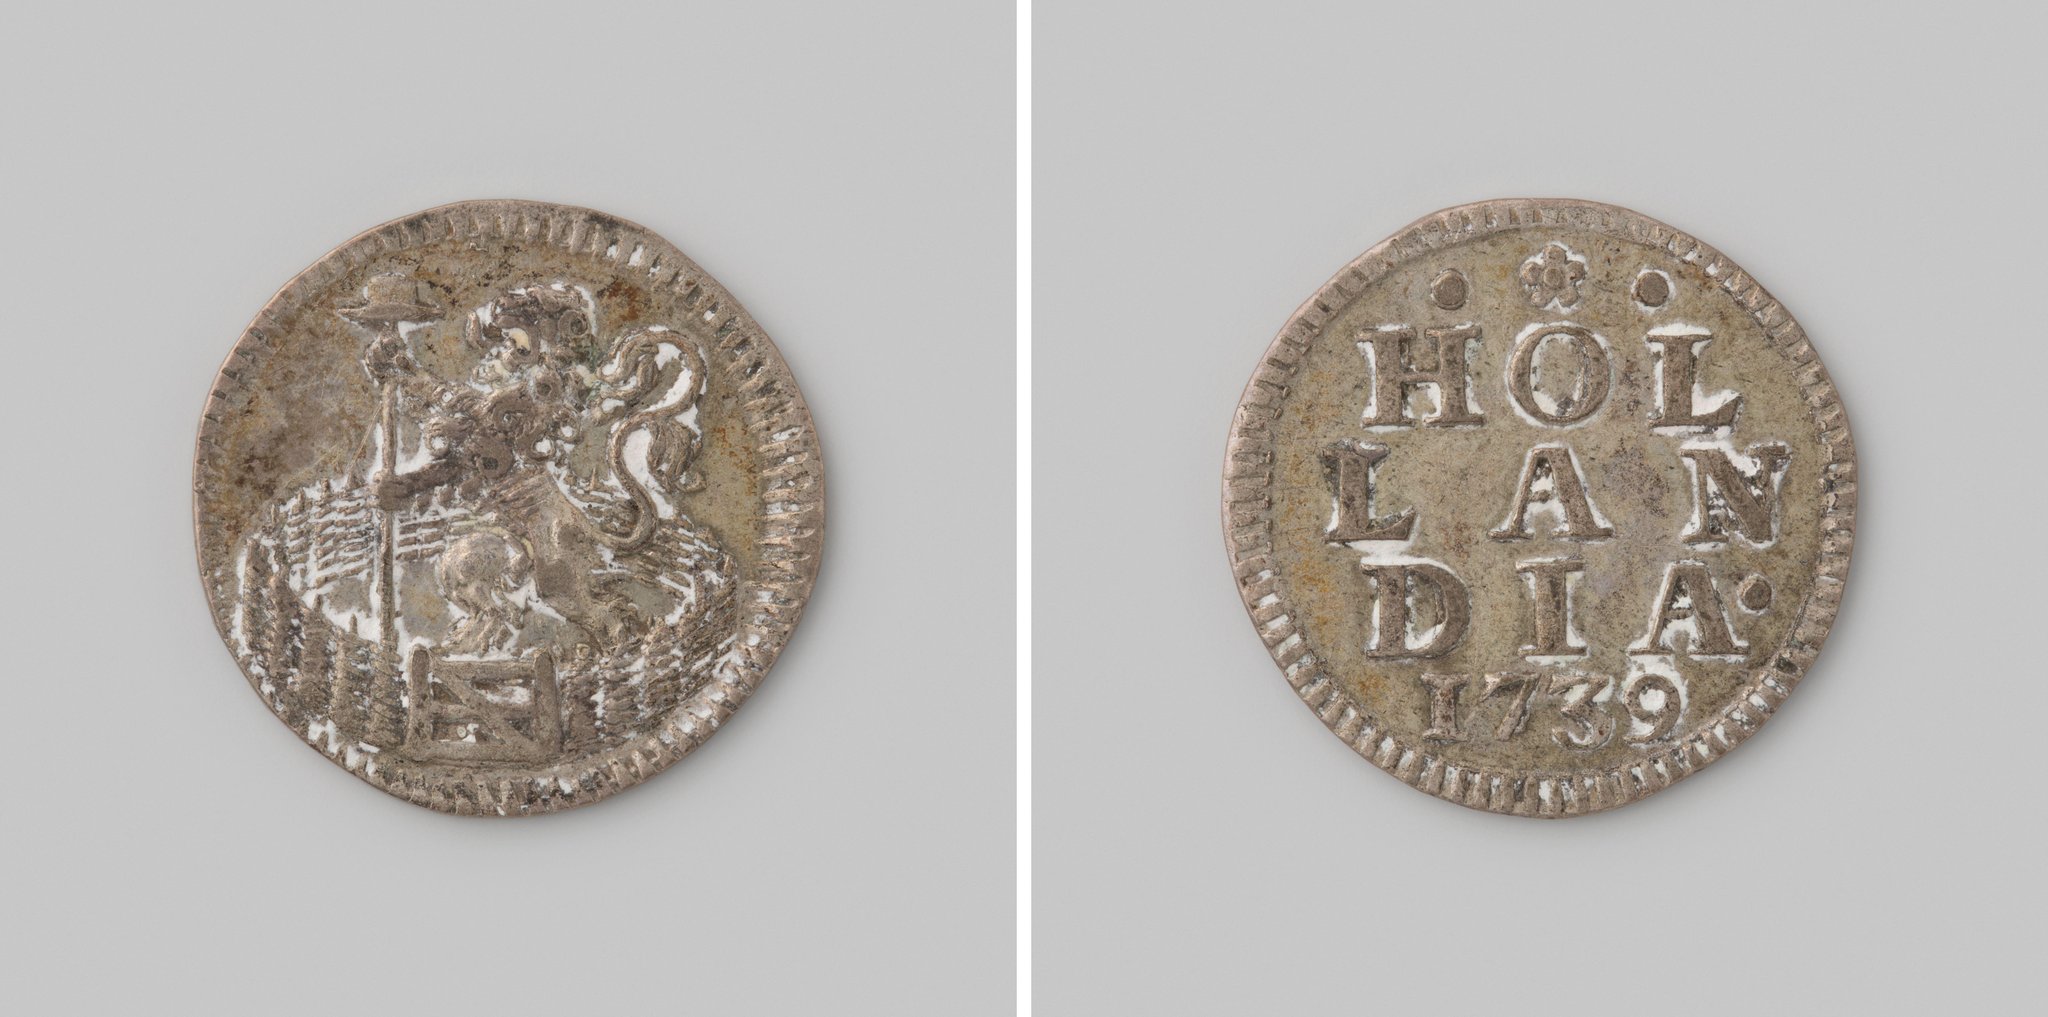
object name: coin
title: Holland, duit, 1739. Afslag in zilver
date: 1739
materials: silver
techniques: striking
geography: dordrecht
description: Zilveren munt. Voorzijde: binnen omheining staande leeuw met vrijheidshoed op speer. Keerzijde: opschrift: provincienaam in drie regels, daaronder jaartal.